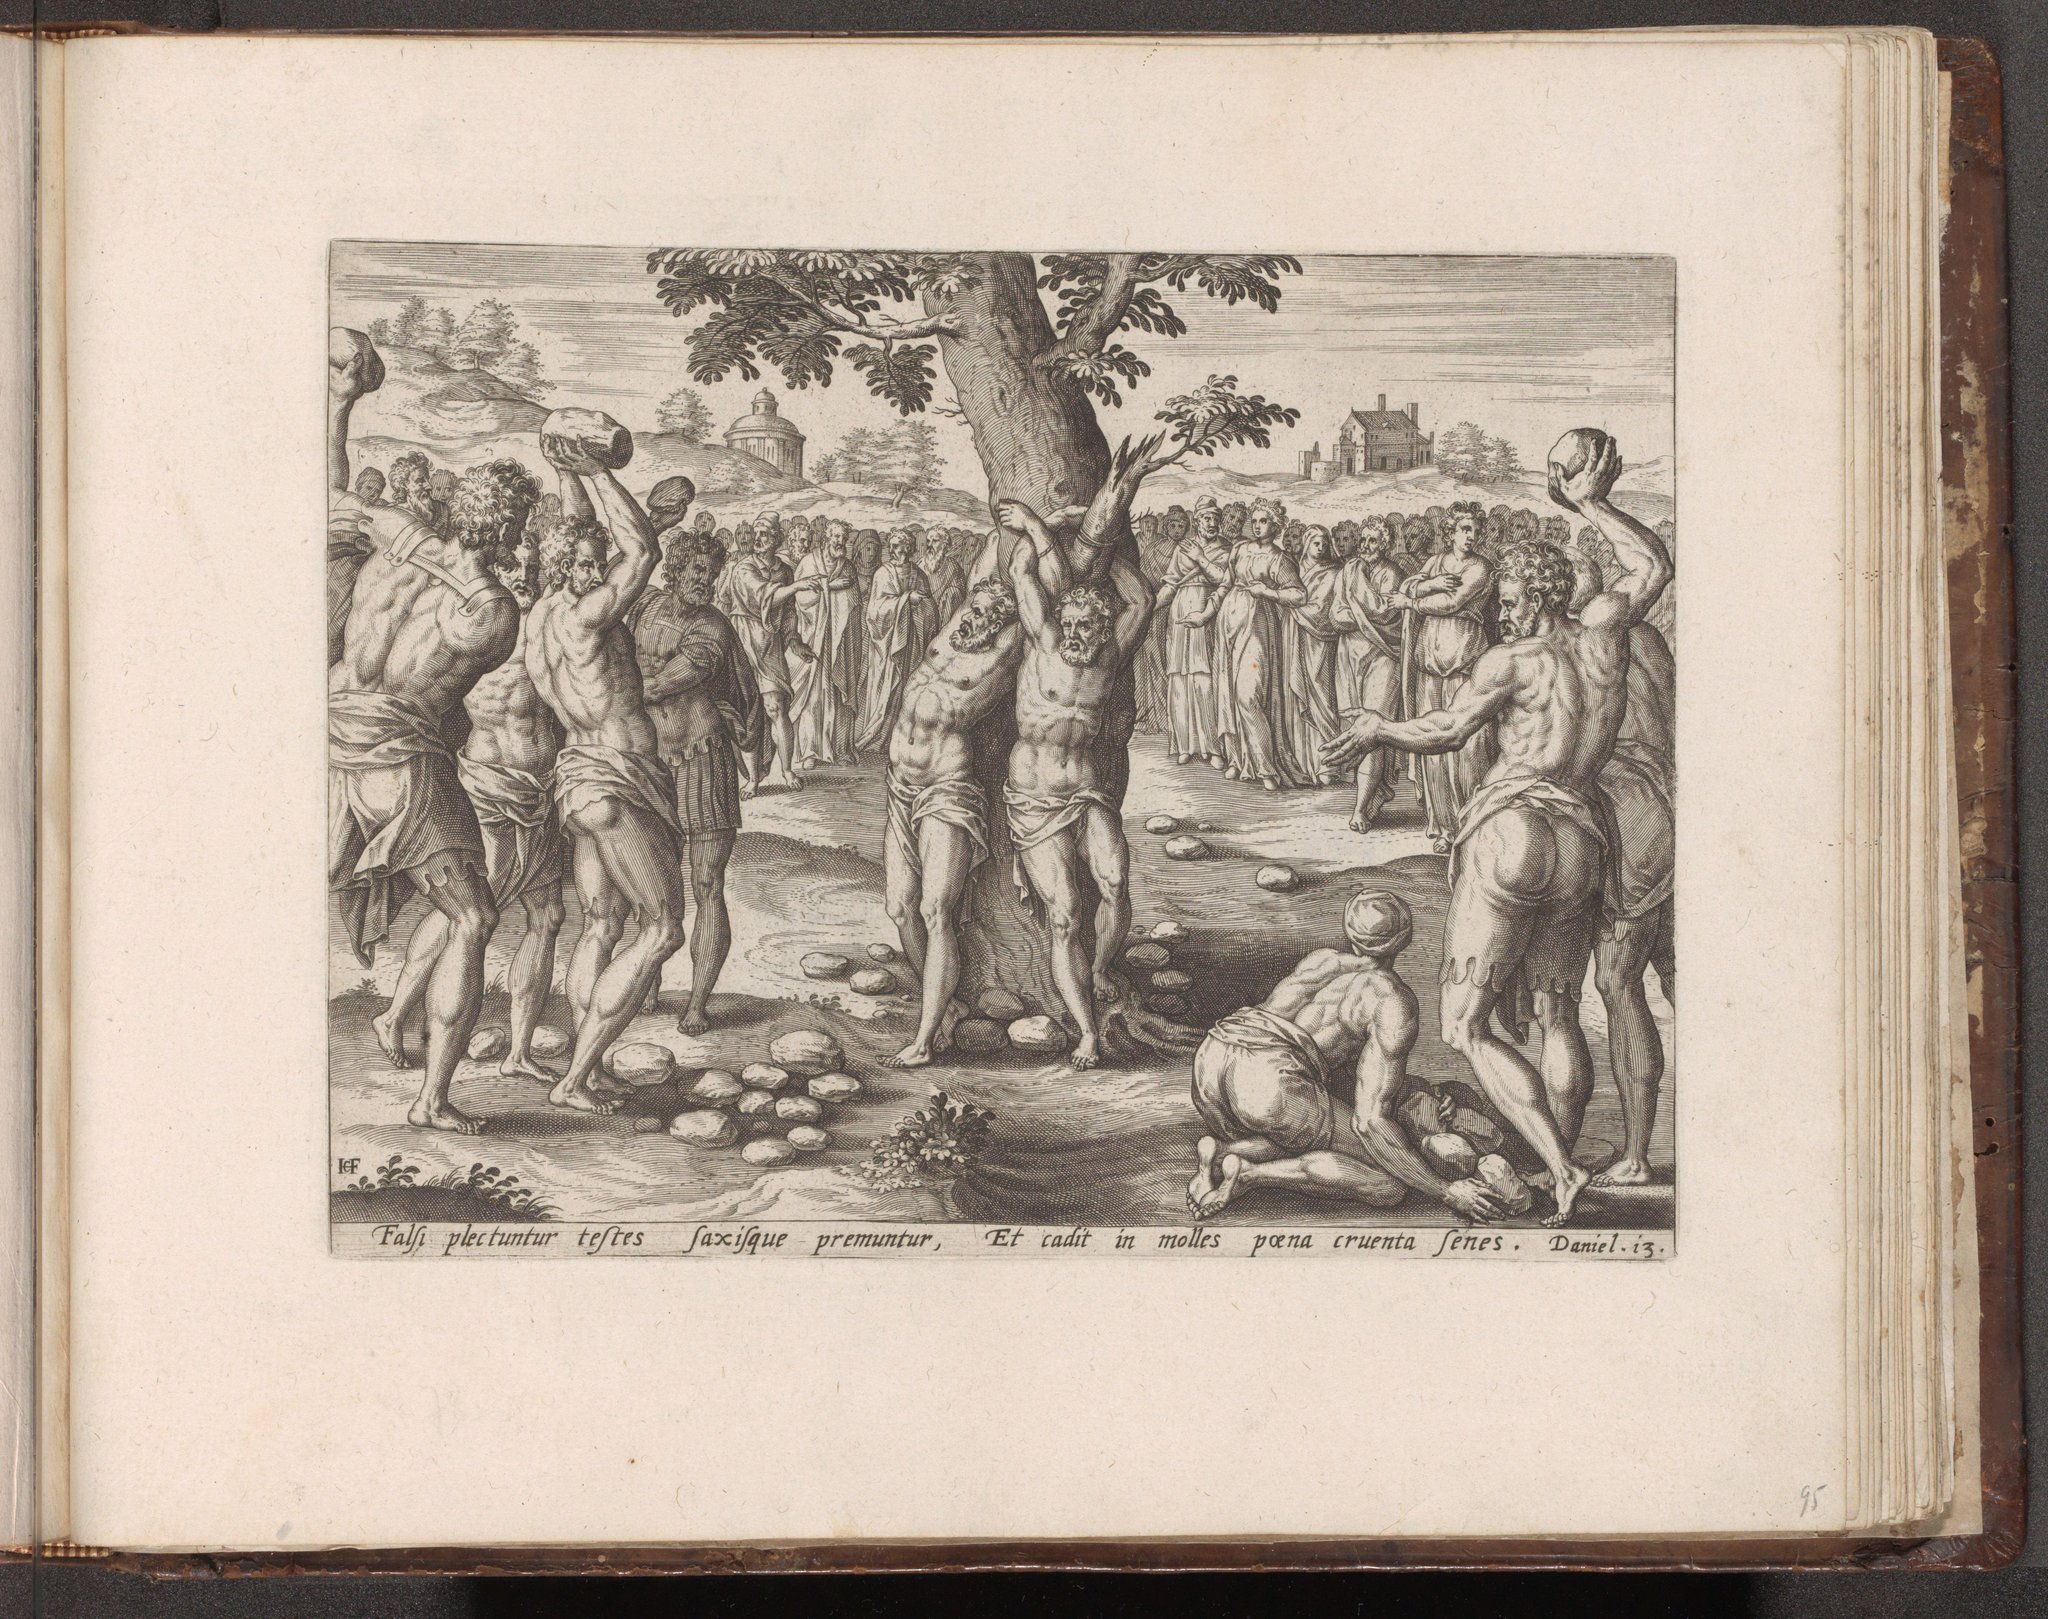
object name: print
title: Historia Susannae (...)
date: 1579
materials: paper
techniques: engraving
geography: antwerp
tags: the elders are stoned to death ~ story of susanna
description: De twee ouderlingen die Susanna vals hebben beschuldigd worden aan een boom gebonden en door de menigte gestenigd. Onder de voorstelling een verwijzing in het Latijn naar de Bijbeltekst in Dan. 13:62. Prent maakt deel uit van een album.